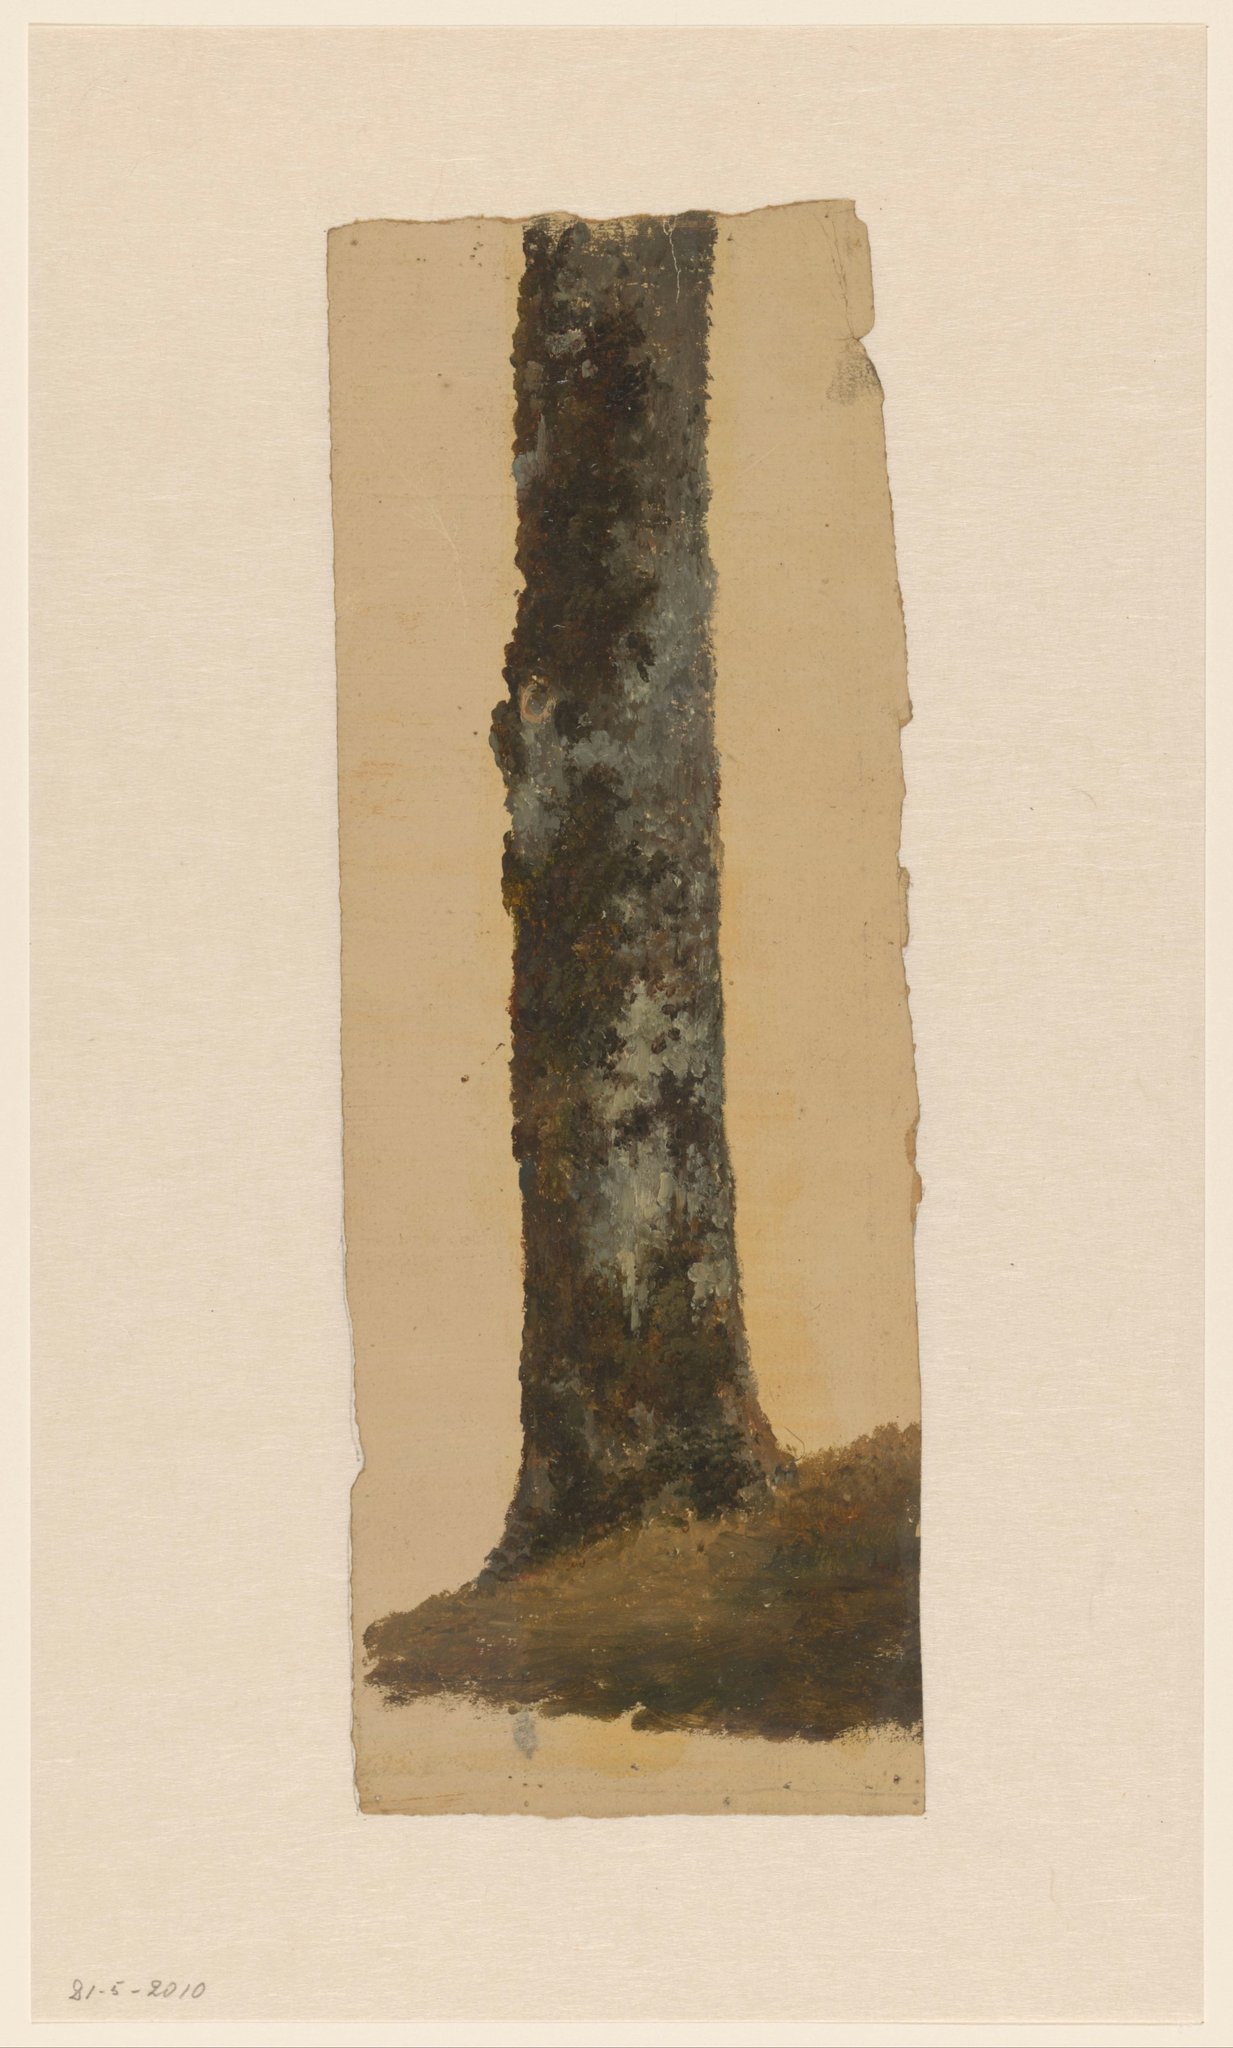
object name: drawing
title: Studie van een boomstam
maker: cornelis johannes de vogel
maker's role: draughtsman, painter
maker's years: 1824-1879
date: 1834-1879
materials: oil, paper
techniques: brush